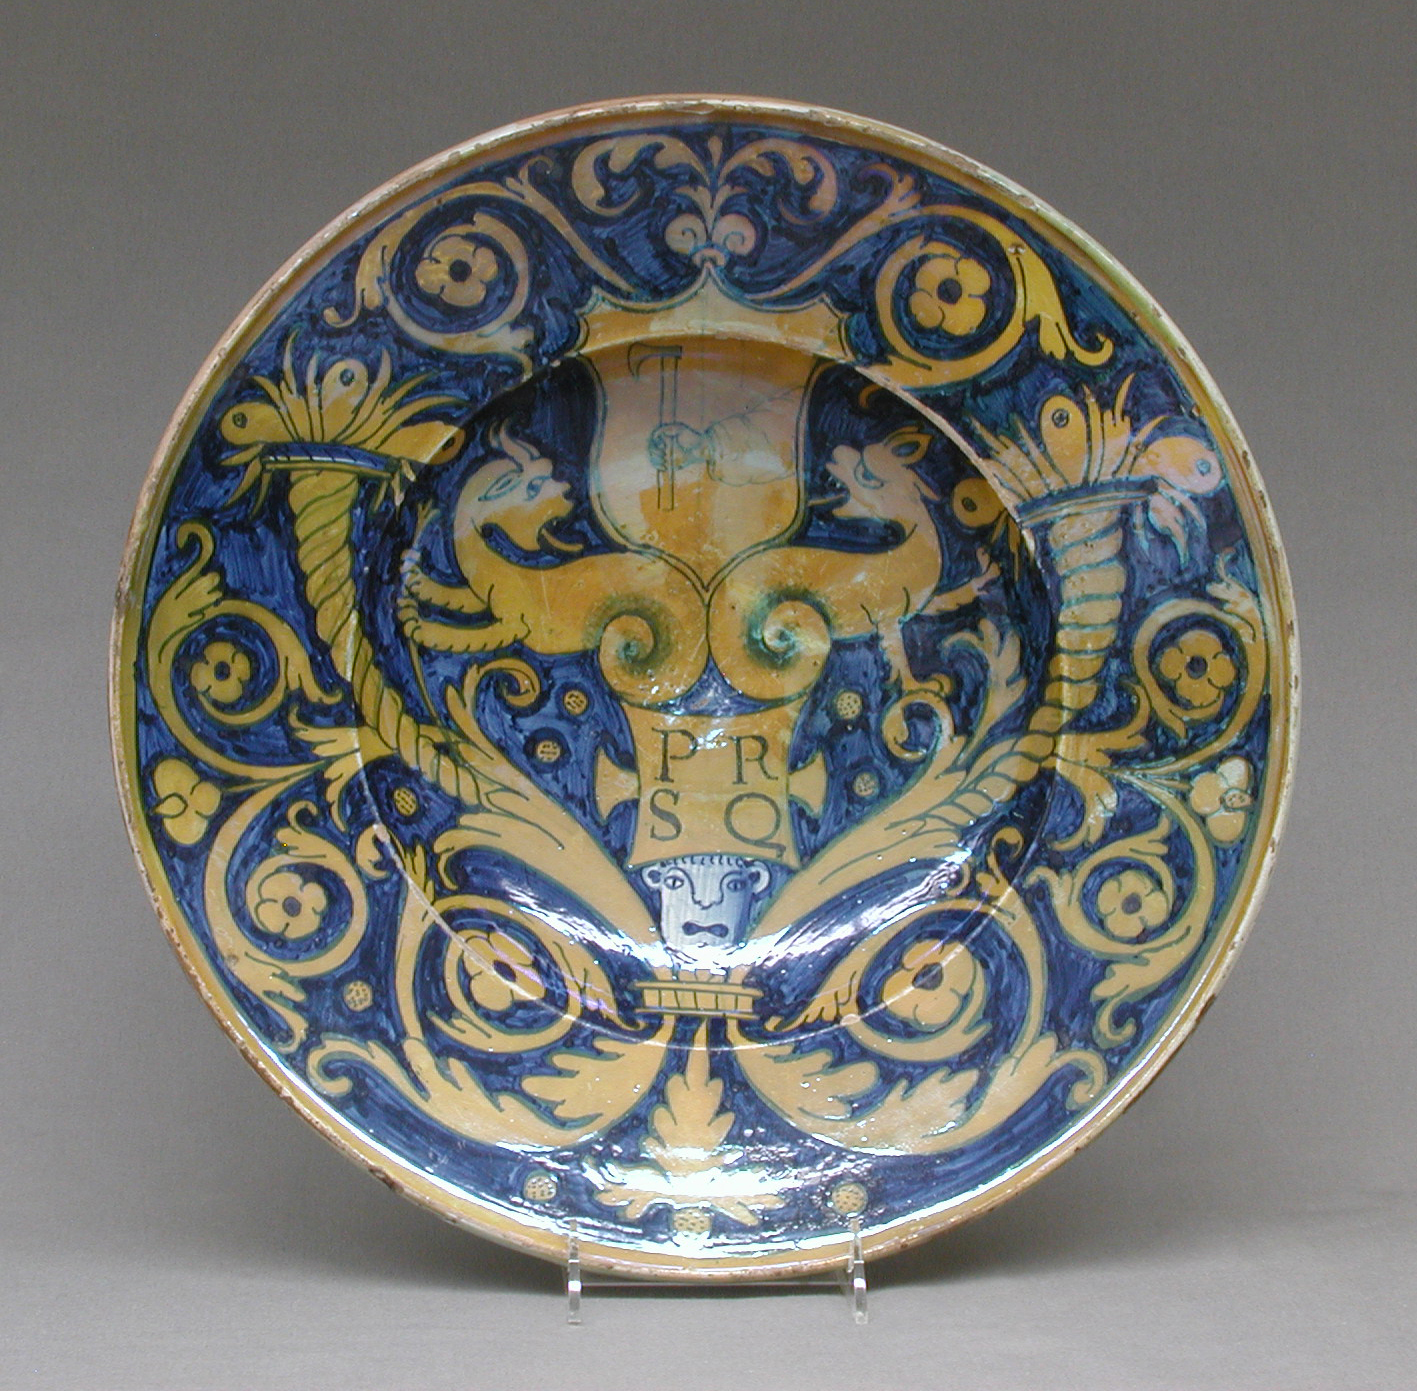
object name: dish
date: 1530-1540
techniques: maiolica, glazing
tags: animals,flowers,coat of arms